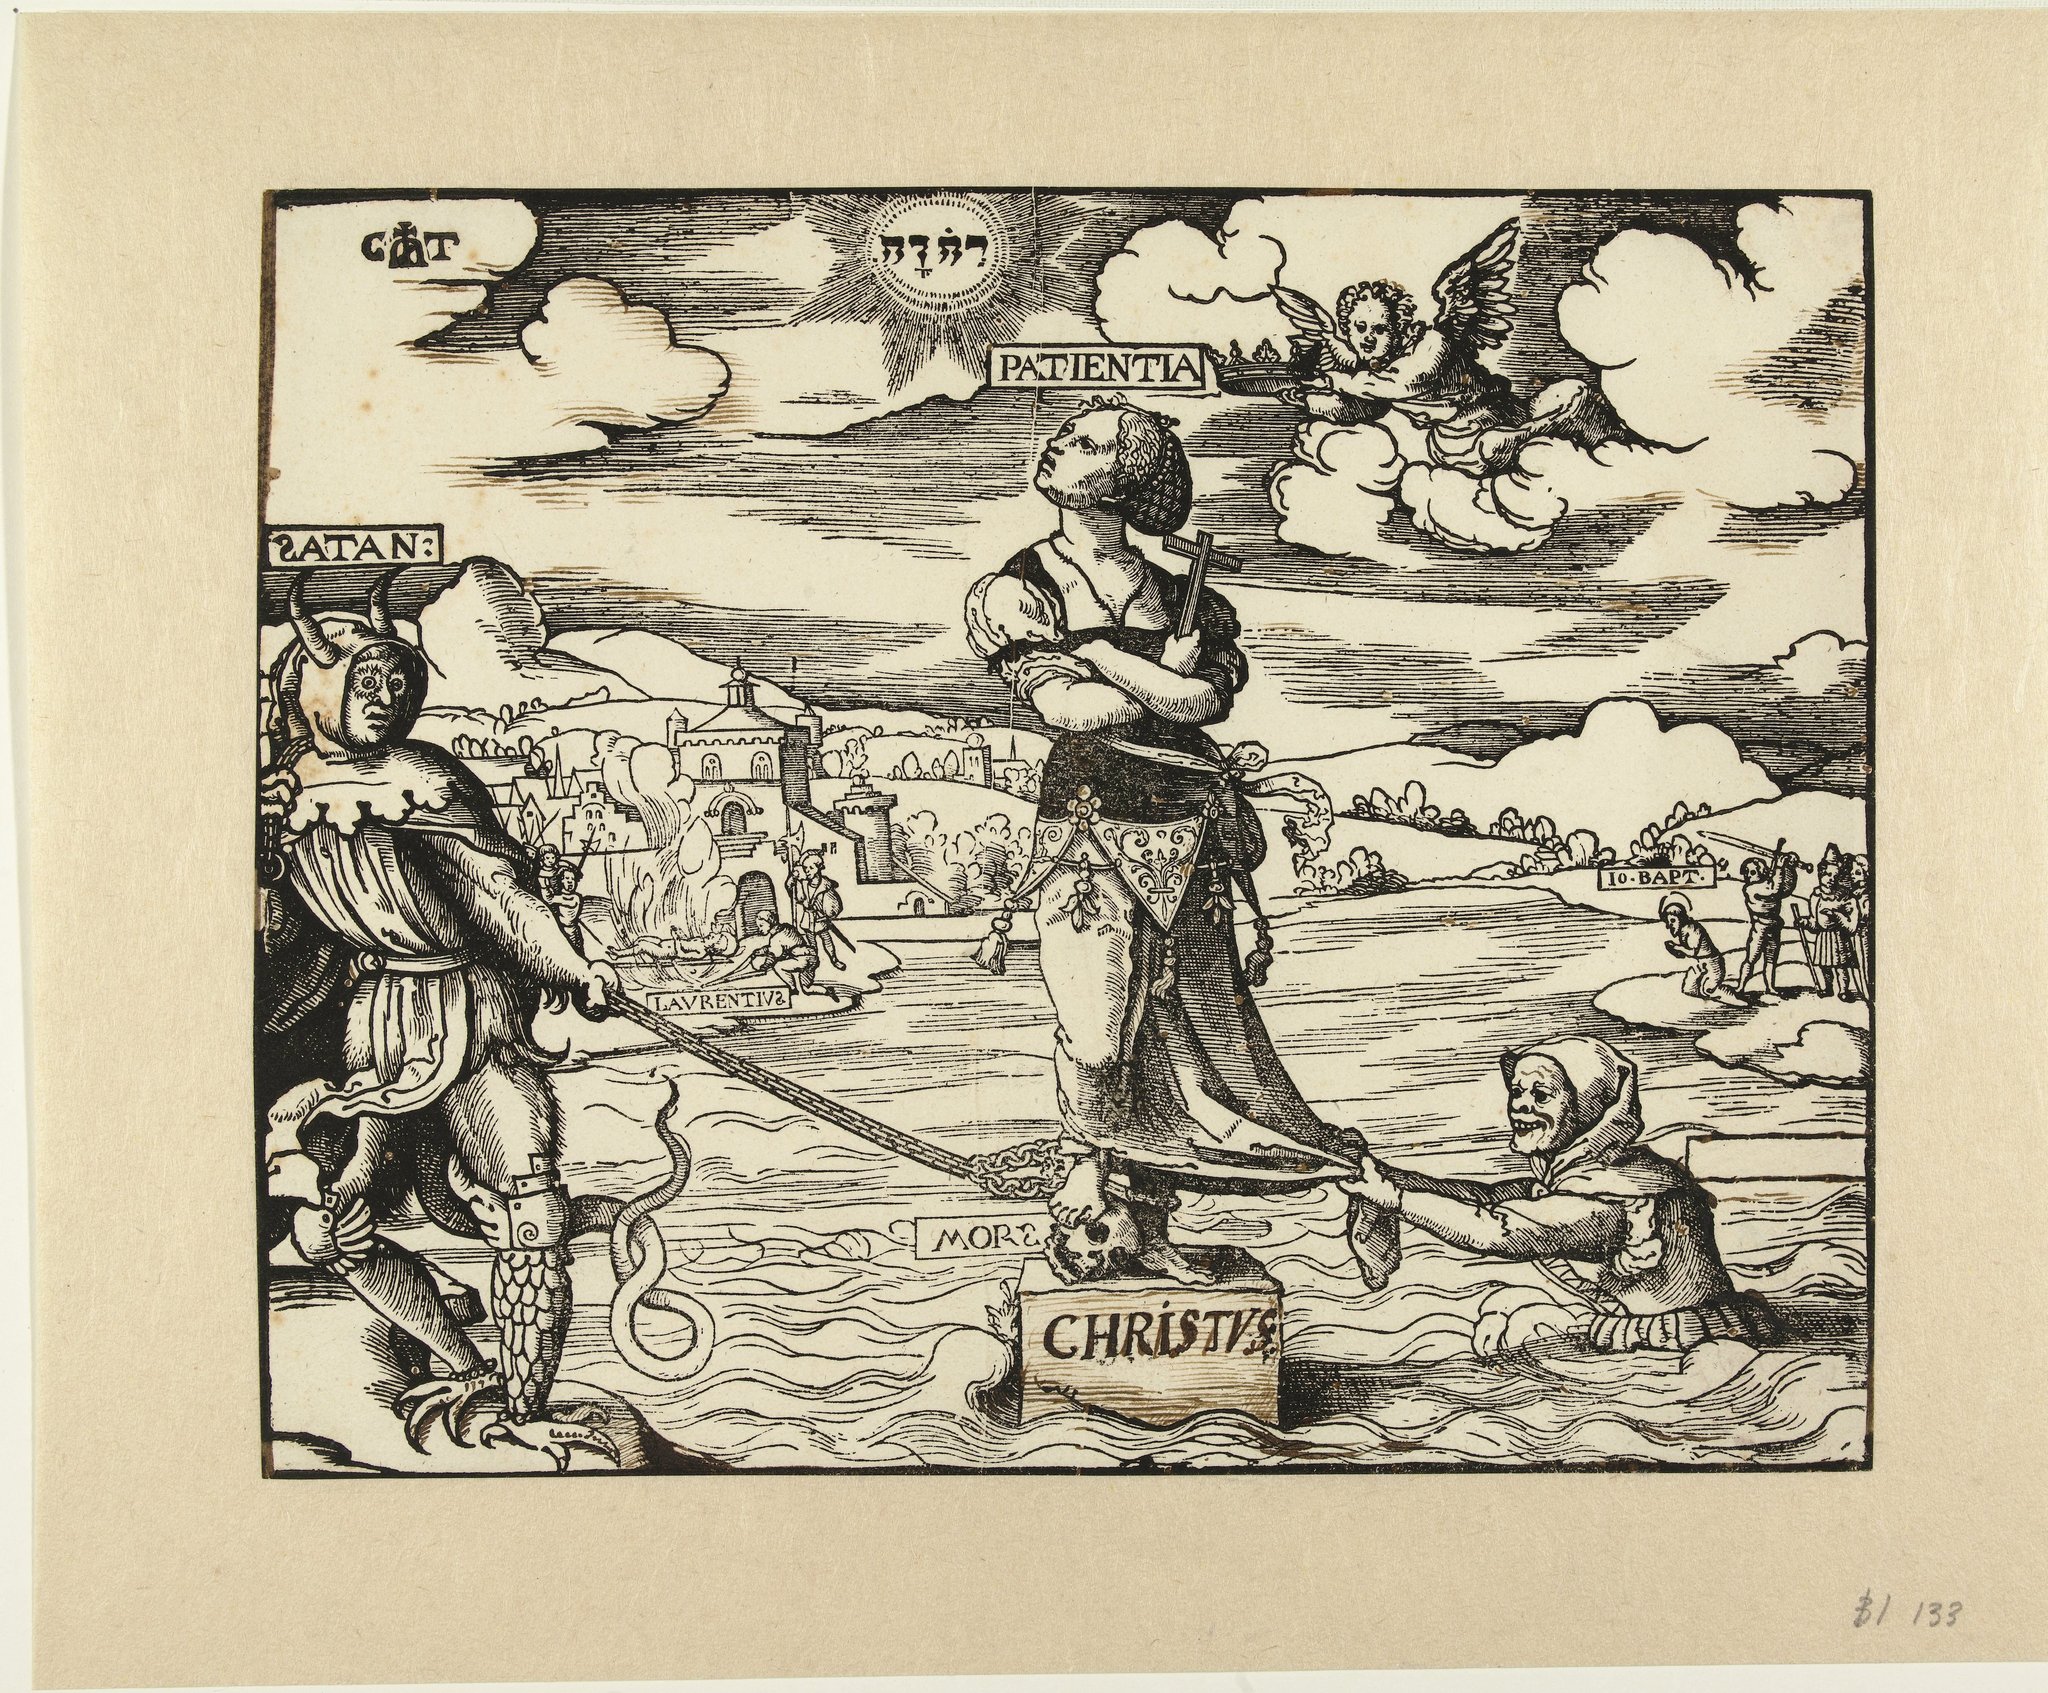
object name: print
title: Geduld (Patientia) op een steen in het water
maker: cornelis anthonisz.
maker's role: draughtsman, painter, print maker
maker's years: 1499-1553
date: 1507-1553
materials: paper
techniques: pen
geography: low countries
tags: st. laurence is roasted on a gridiron, patience; 'patienza' (ripa), devil(s) and demons: satan, the beheading of john the baptist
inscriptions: collector's mark: Lugt 240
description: Geduld (Patientia) op een steen in het water, voet leunt op schedel, kruis in haar hand. Haar been zit aan ketting die Satan aan haar rechterkant vast heeft. Aan andere kant trekt een figuur aan haar mantel. Engel komt aanvliegen met kroon. In landschap op achtergrond de onthoofding van Johannes de Doper en het martelaarschap van de heilige Laurentius. Het woord Christus, te zien op de steen, is hier niet gedrukt, maar met pen geschreven in twee kleuren inkt.